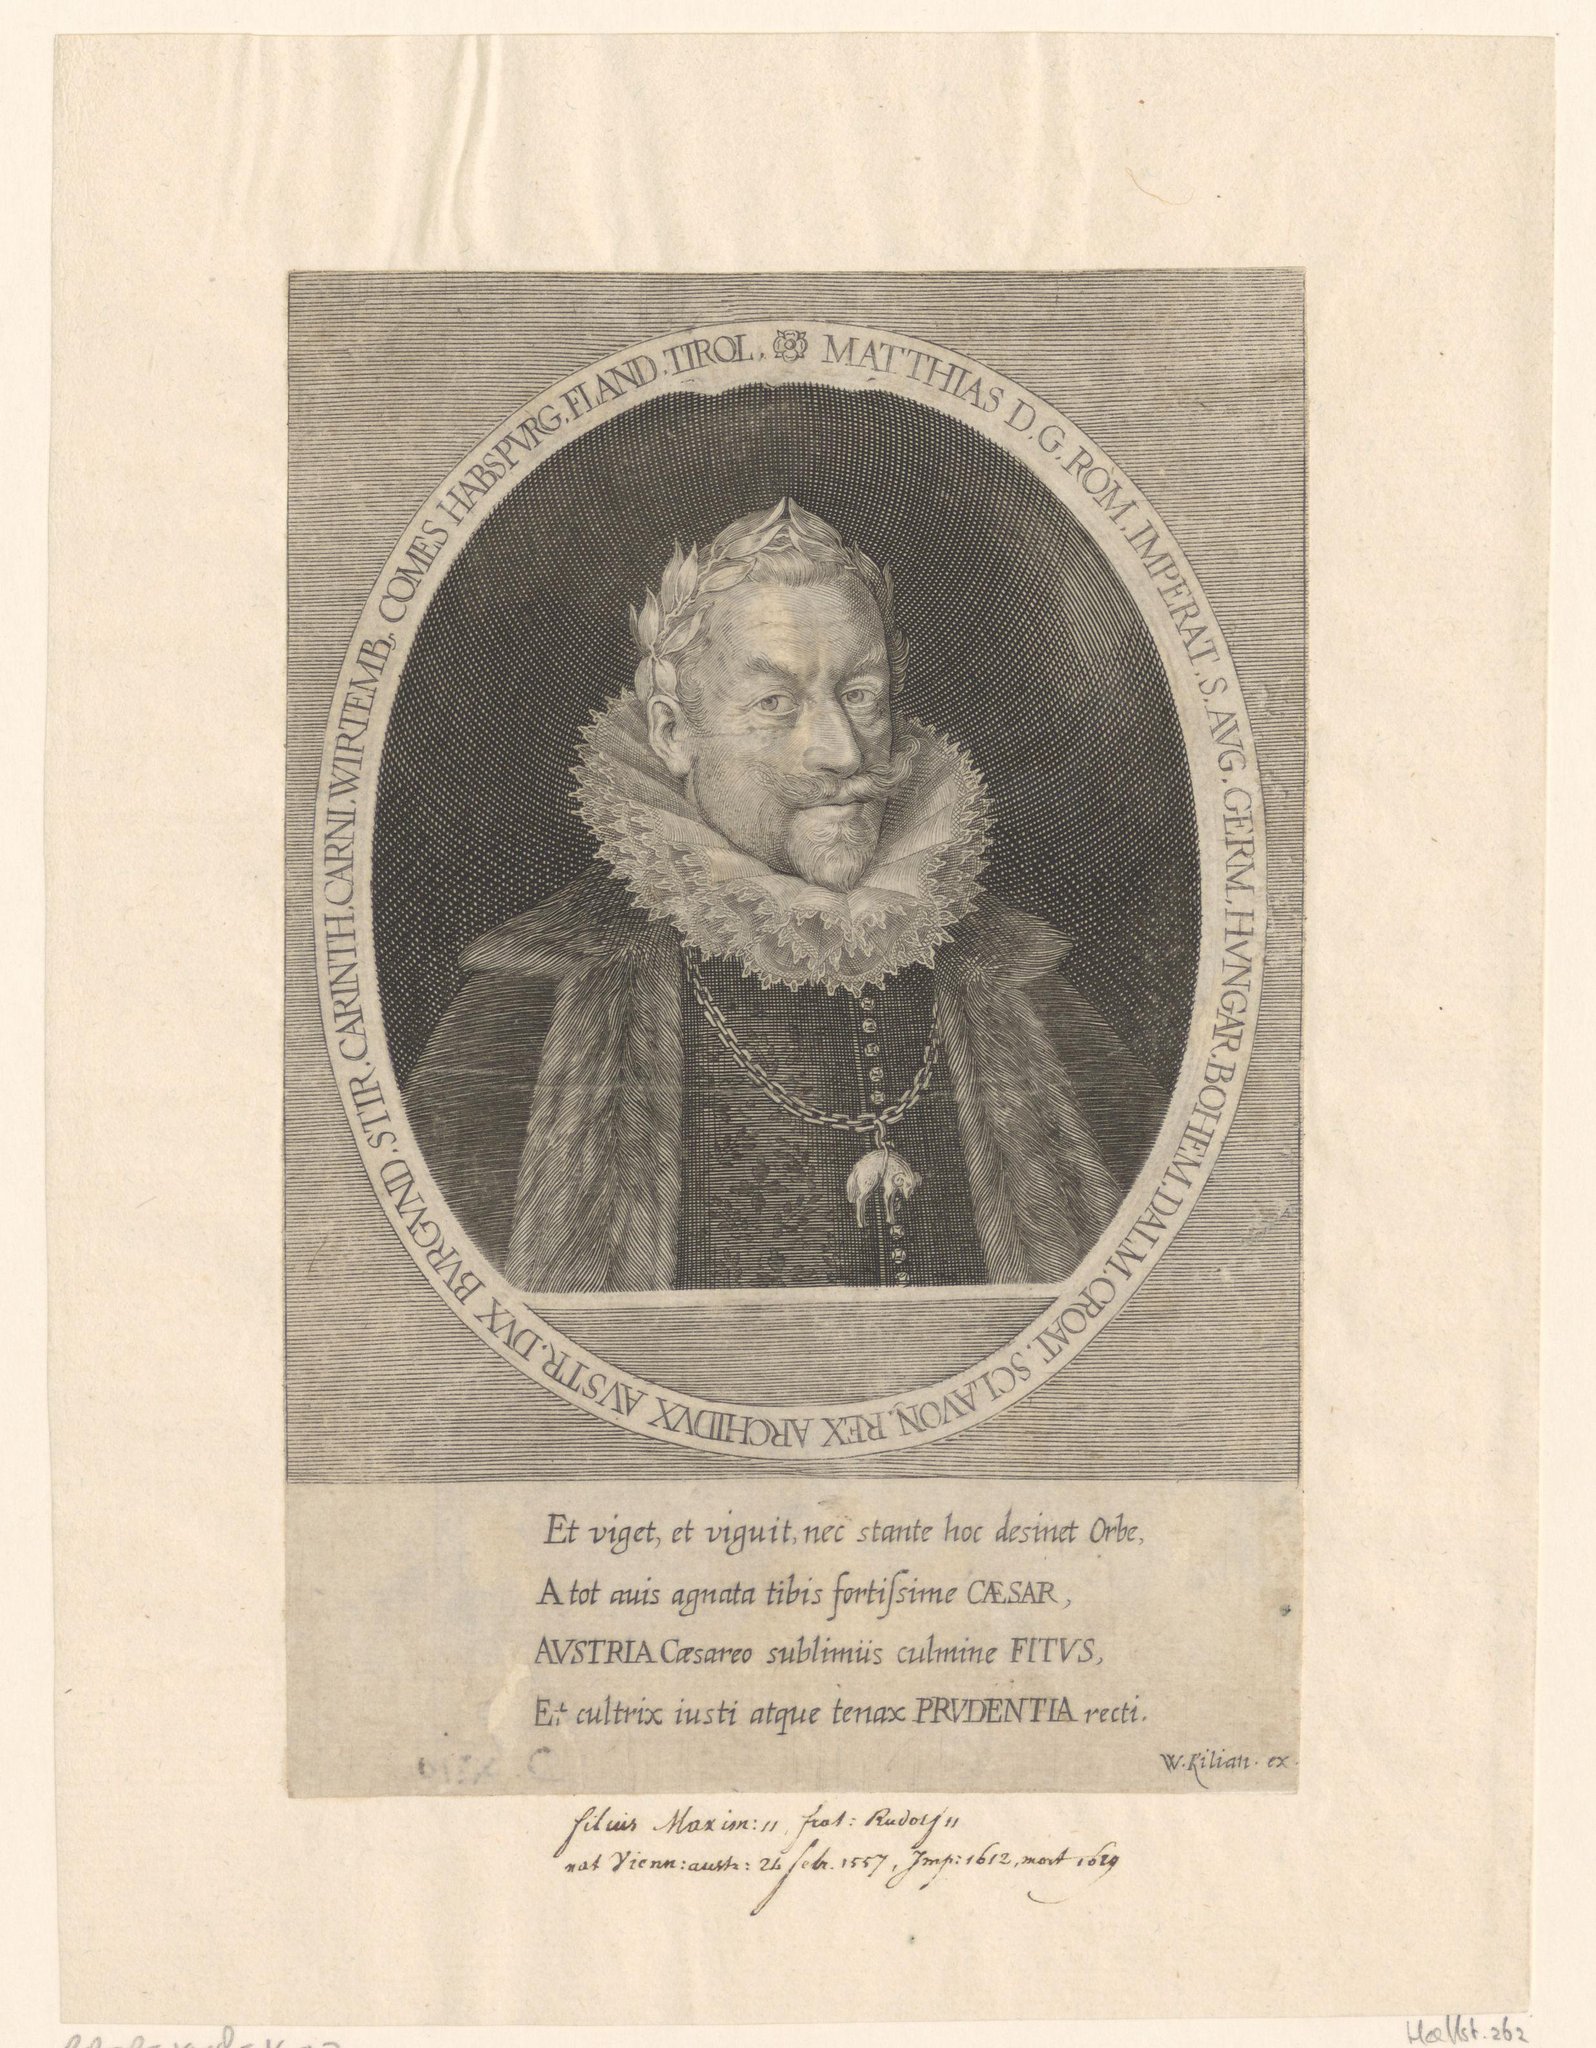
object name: print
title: Portret van keizer Matthias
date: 1591-1662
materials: paper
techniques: engraving, etching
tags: vienna, matthias van oostenrijk (rooms-duits keizer), historical persons, ruler, sovereign, knighthood order of the golden fleece - insignia of a knighthood order, e.g.: badge, chain (with name of order)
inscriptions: collector's mark: Lugt 2228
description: Tekst in het Latijn in de omlijsting en in de ondermarge.